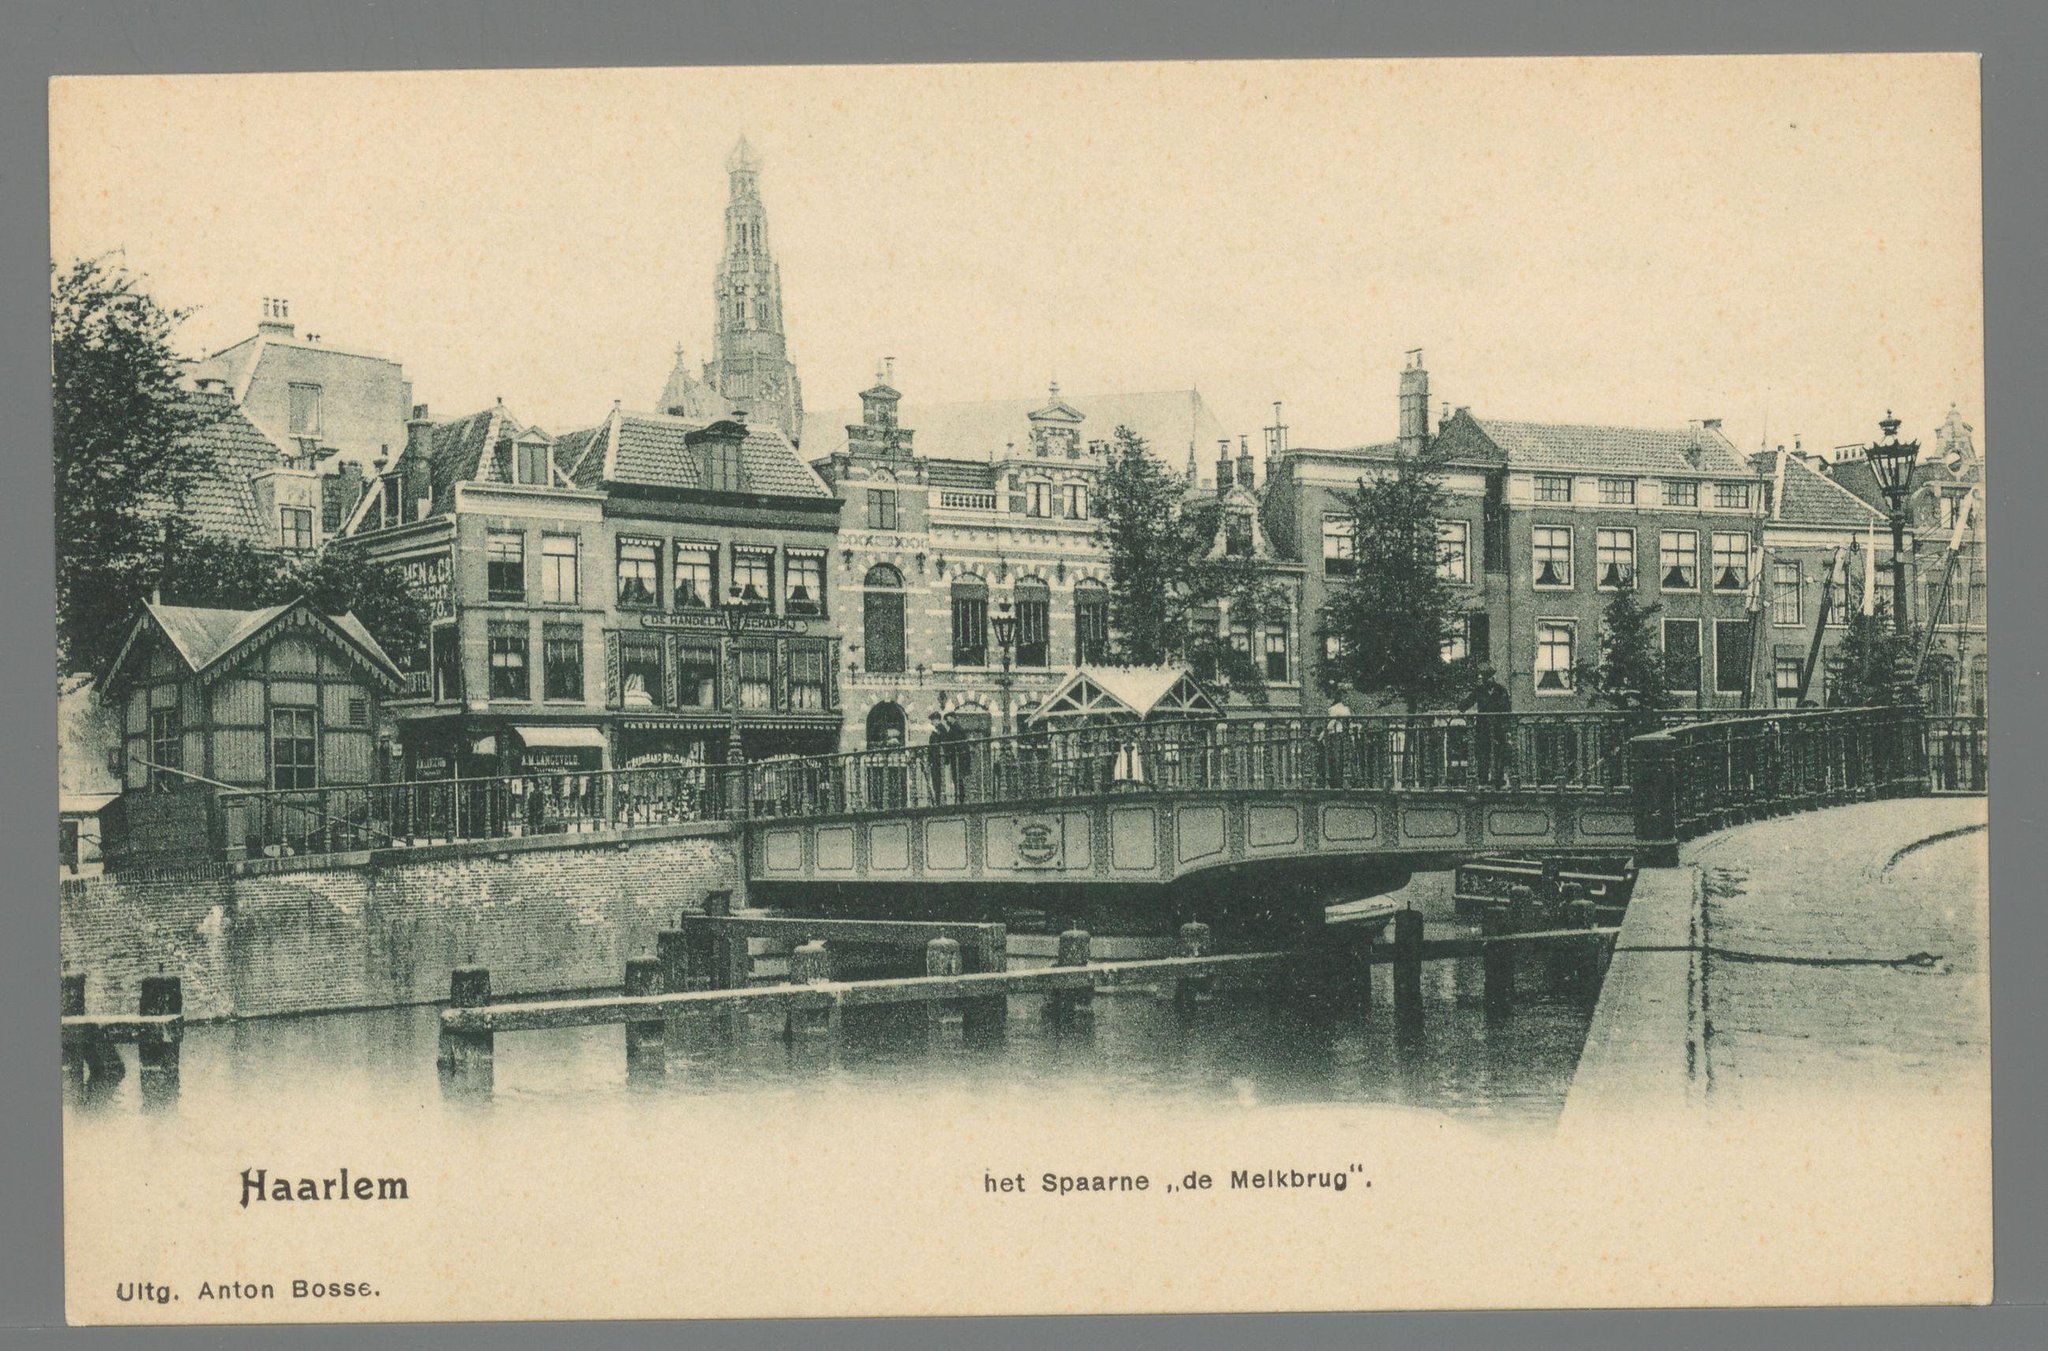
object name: ansichtkaart, prentbriefkaart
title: Haarlem. Het Spaarne "de Melkbrug"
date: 1905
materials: cardboard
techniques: photograph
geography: haarlem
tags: city-view, and landscape with man-made constructions, river, bridge in city across river, canal, etc., parts of church exterior and annexes: tower, haarlem